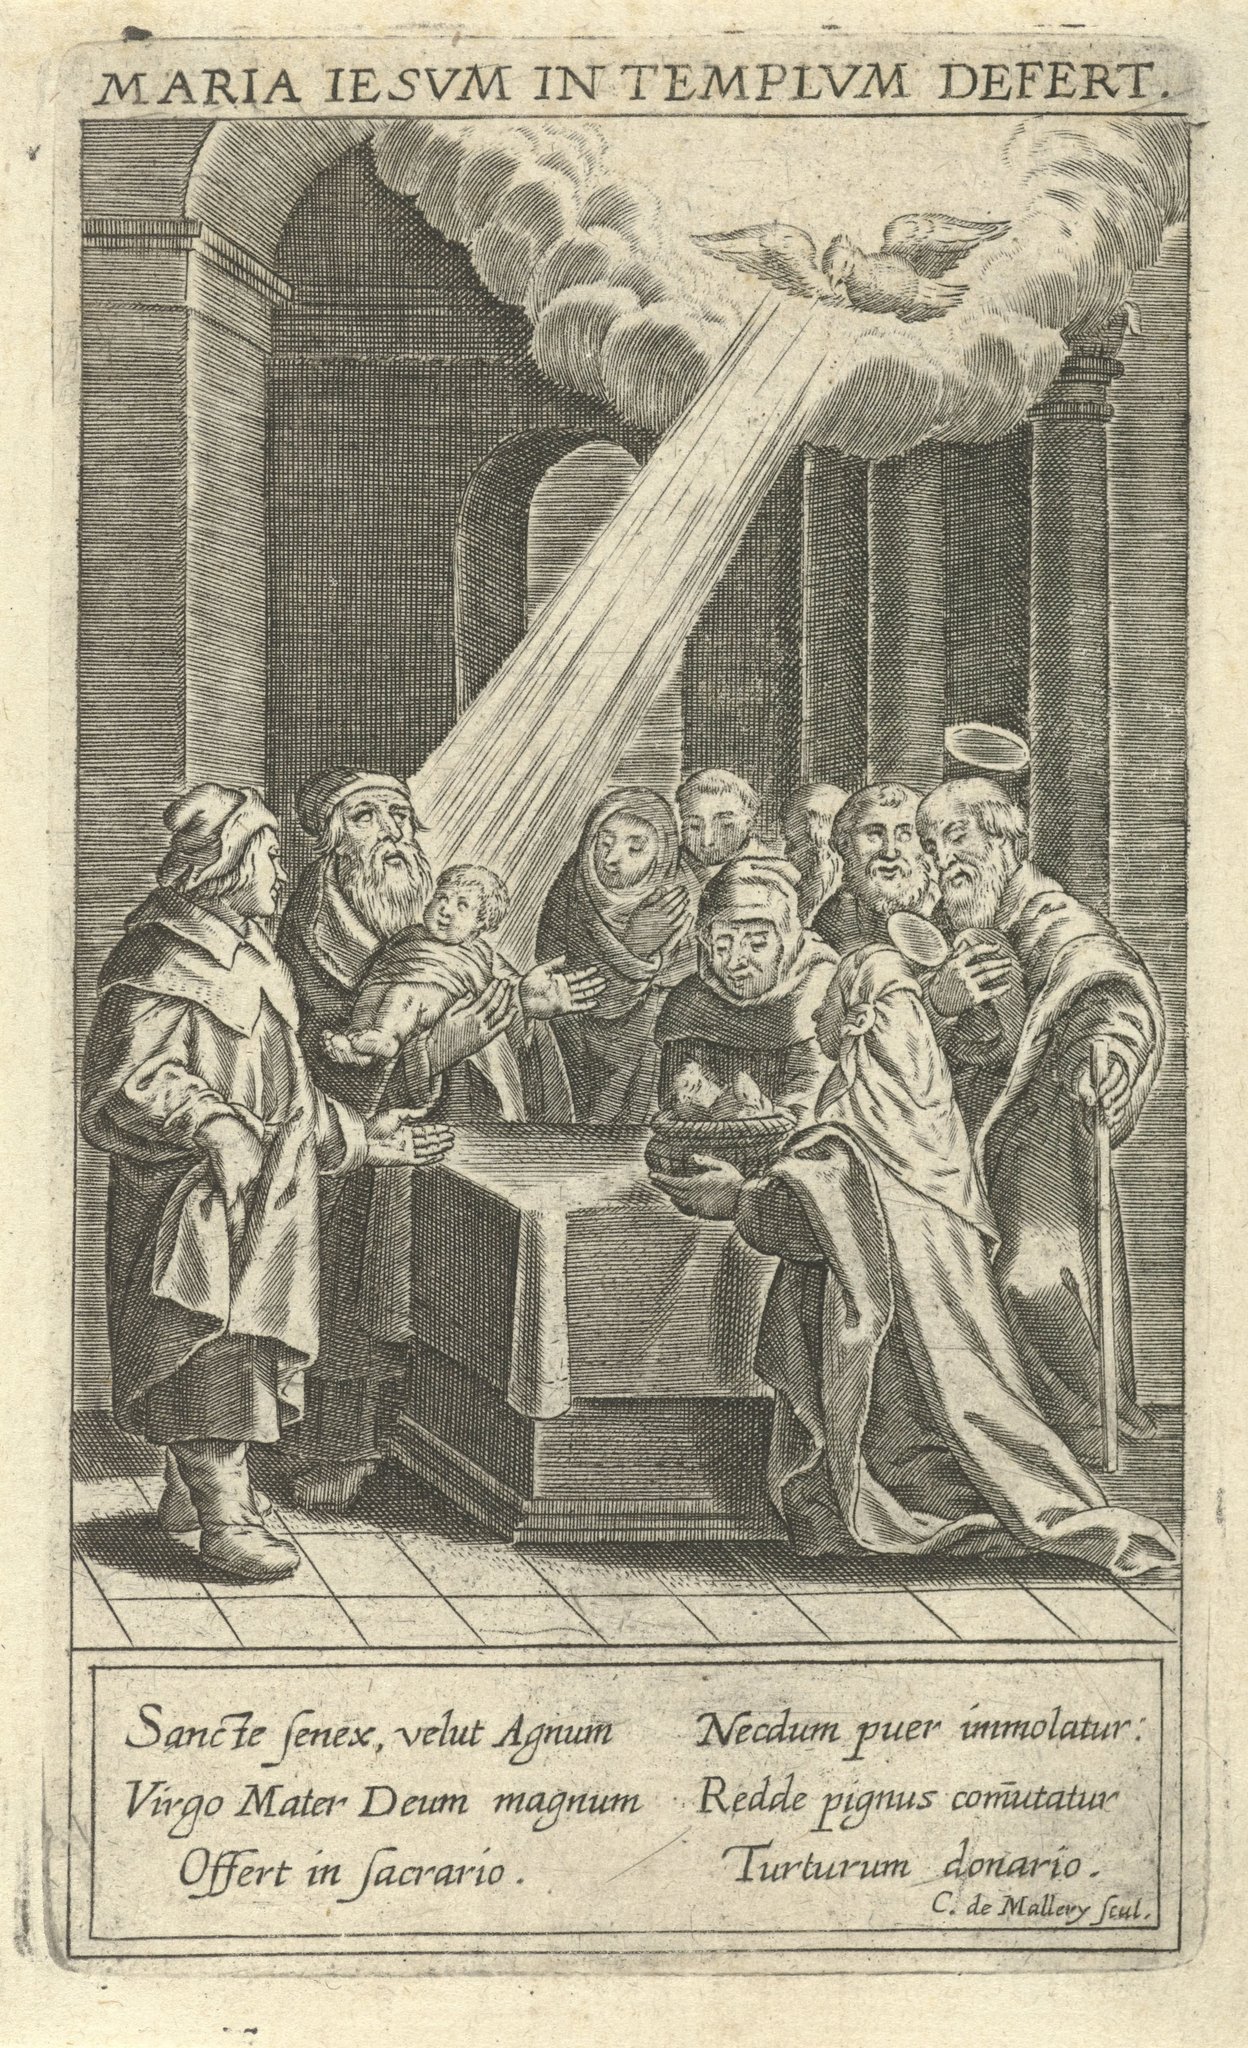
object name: print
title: Presentatie van Christus in de tempel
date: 1581-1645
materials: paper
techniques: engraving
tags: presentation of the christ-child in the temple, usually simeon (and anna) present (luke 2:22-39)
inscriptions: collector's mark: Lugt 2228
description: Het Christuskind ligt in de tempel in de armen van Simeon en wordt beschenen door een stralenkrans van de duif als symbool voor de Heilige Geest. Voor het altaar een knielende Maria met een mand met daarin twee duiven, die verwijzen naar de joodse rite van de reiniging van de moeder door het offeren van een duivenpaar. Verbeelding van de Bijbelverzen Luc. 2:22-39. Onder de voorstelling twee kolommen met elk drie regels in het Latijn.